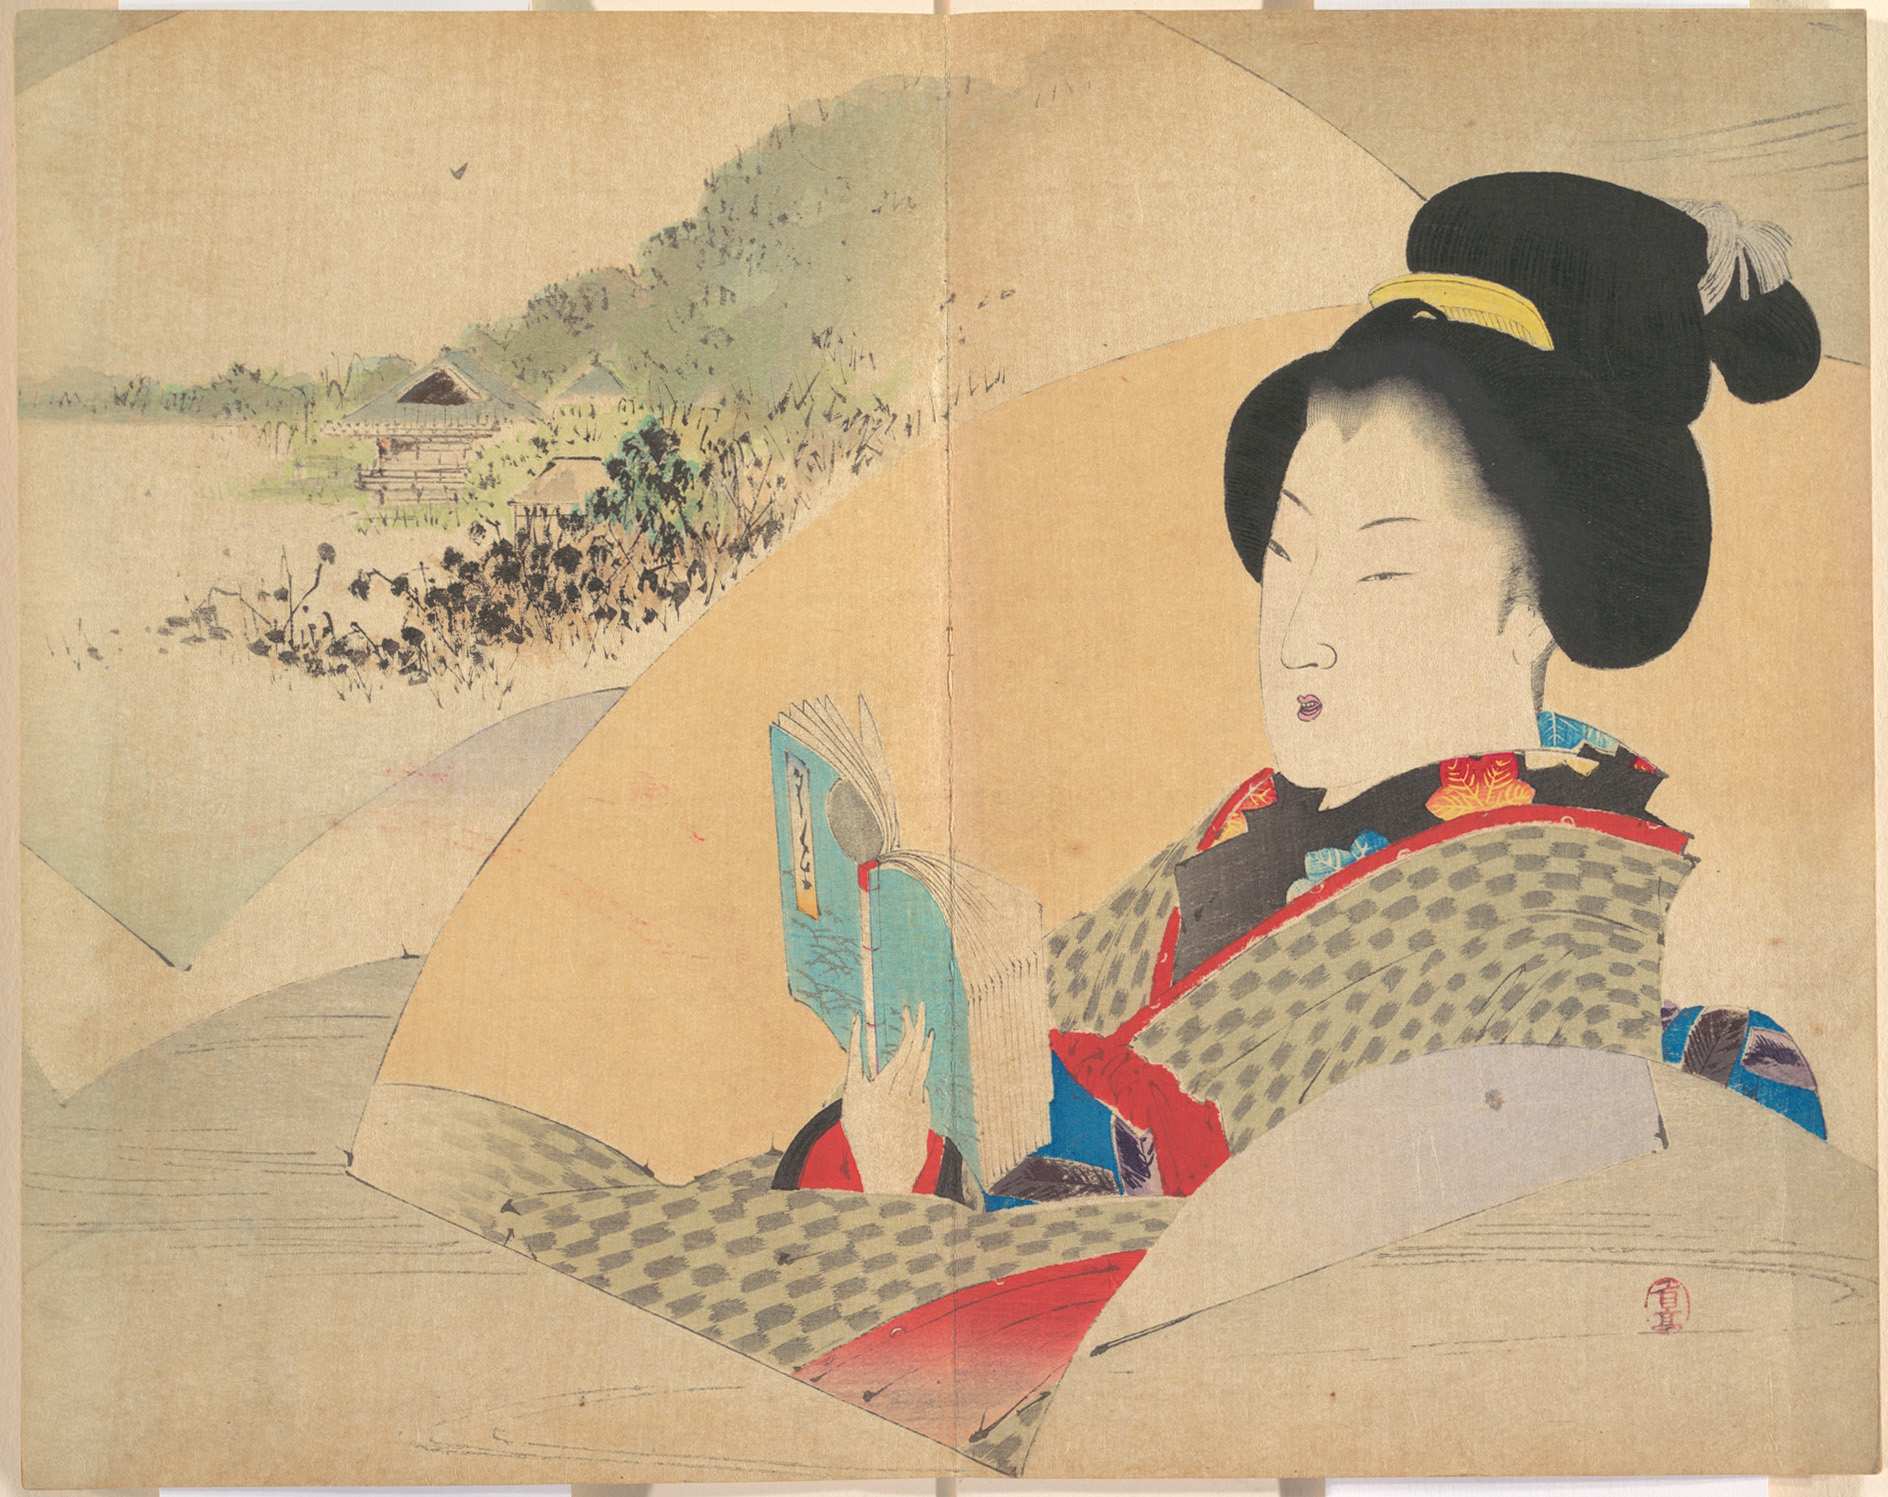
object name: print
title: Beauty Looking at Shinobazu Pond, illustration from Bugei Kurabu (Literary Club)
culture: japanese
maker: watanabe seitei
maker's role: artist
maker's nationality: japanese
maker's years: 1851-1918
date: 1851-1918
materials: ink, paper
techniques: woodblock print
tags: women,reading